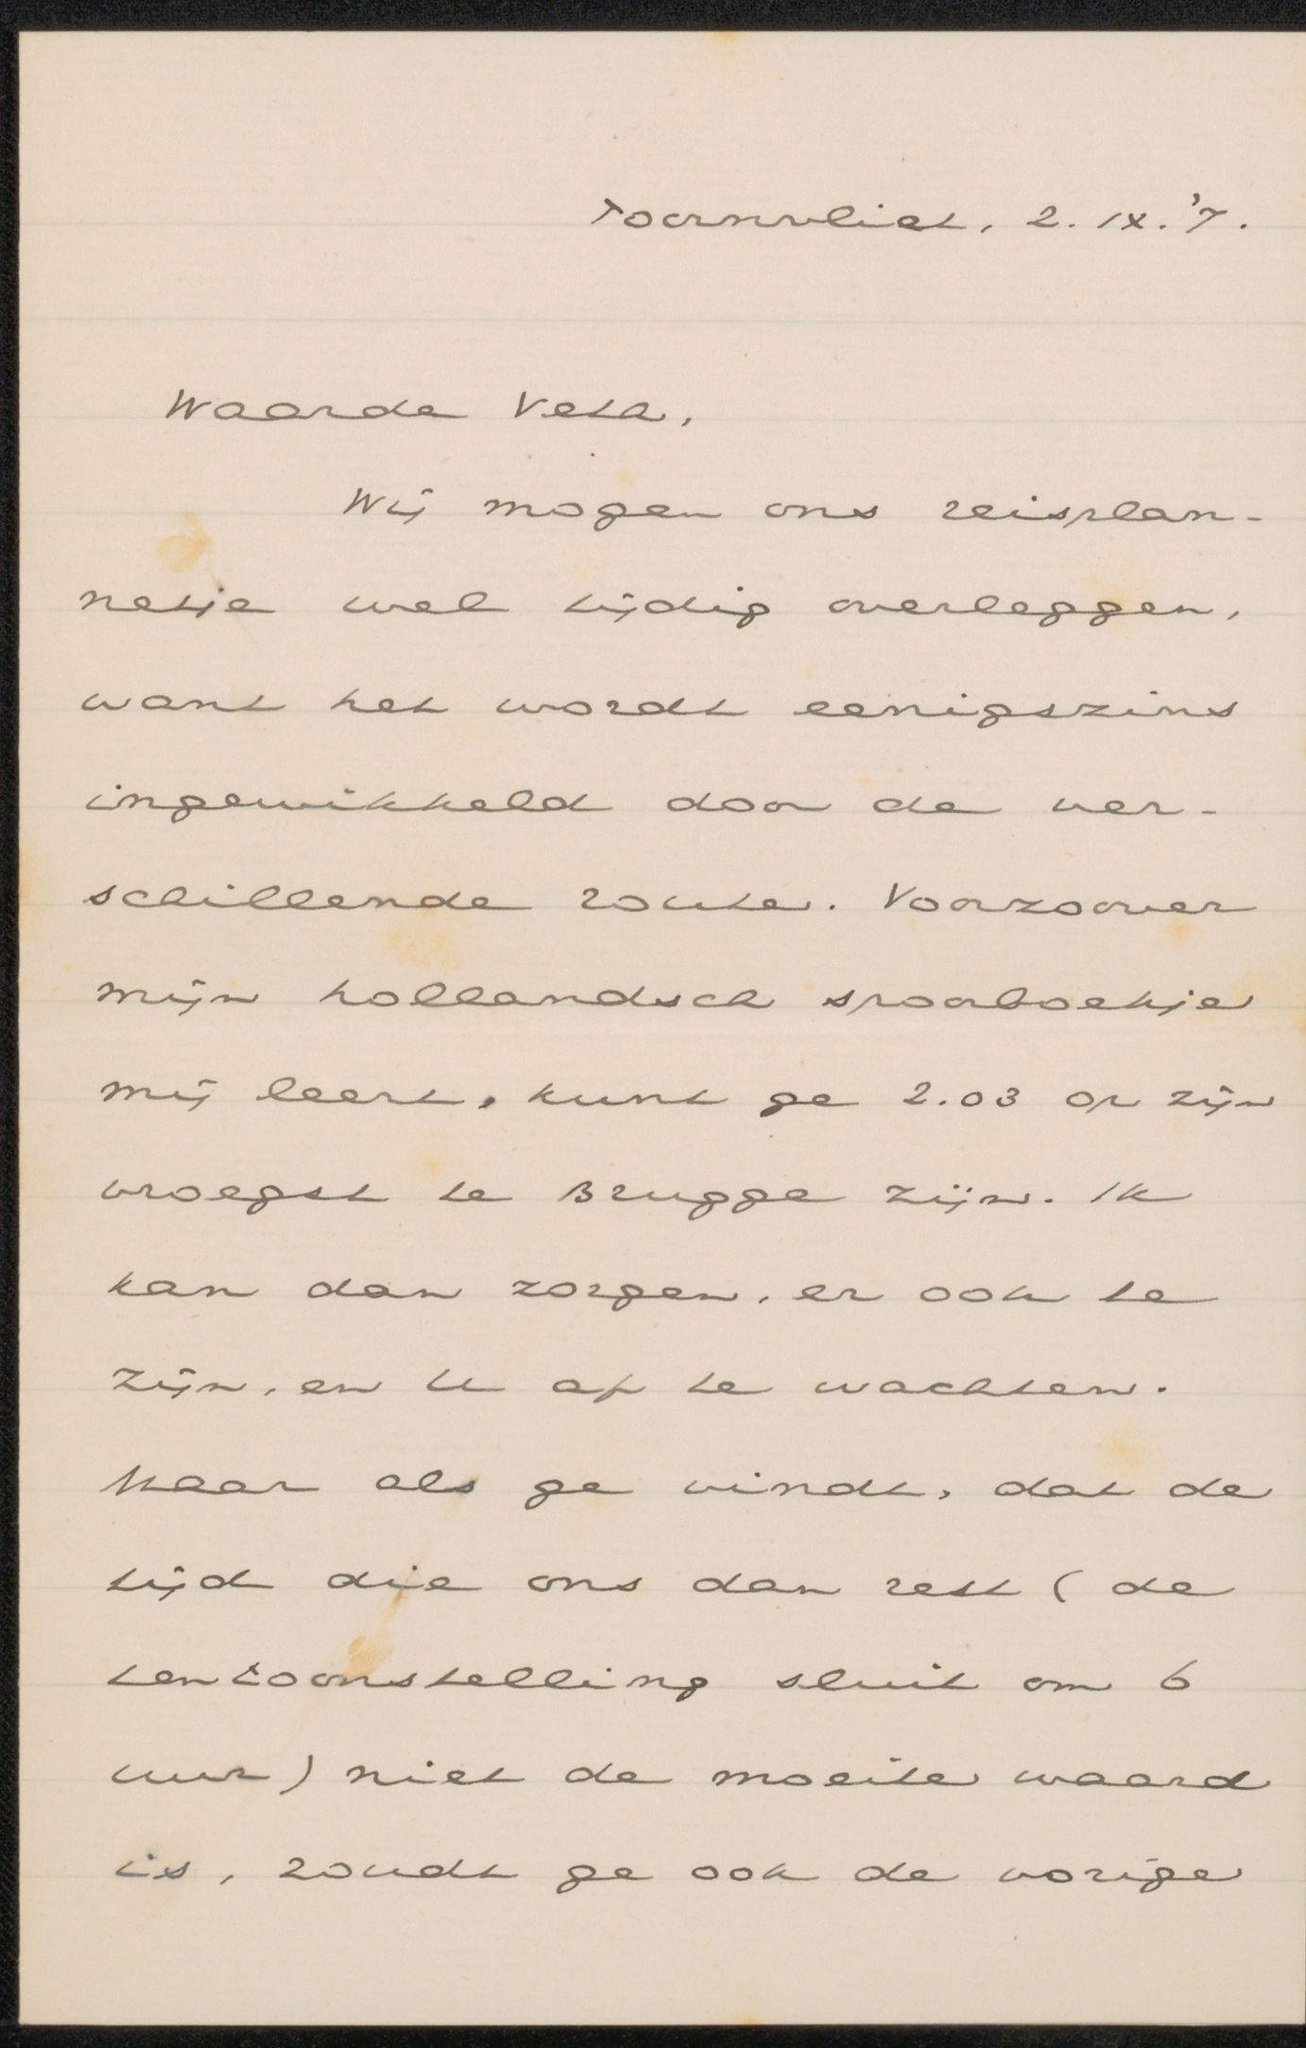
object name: letter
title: Brief aan Jan Veth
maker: johan huizinga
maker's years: 1872-1945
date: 1907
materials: ink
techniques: pen, writing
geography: middelburg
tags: dordrecht, amsterdam, painter, draughtsman, designer, jan veth, exhibition ~ art, flushing, bruges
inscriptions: watermark, collector's mark: ‘RPK’